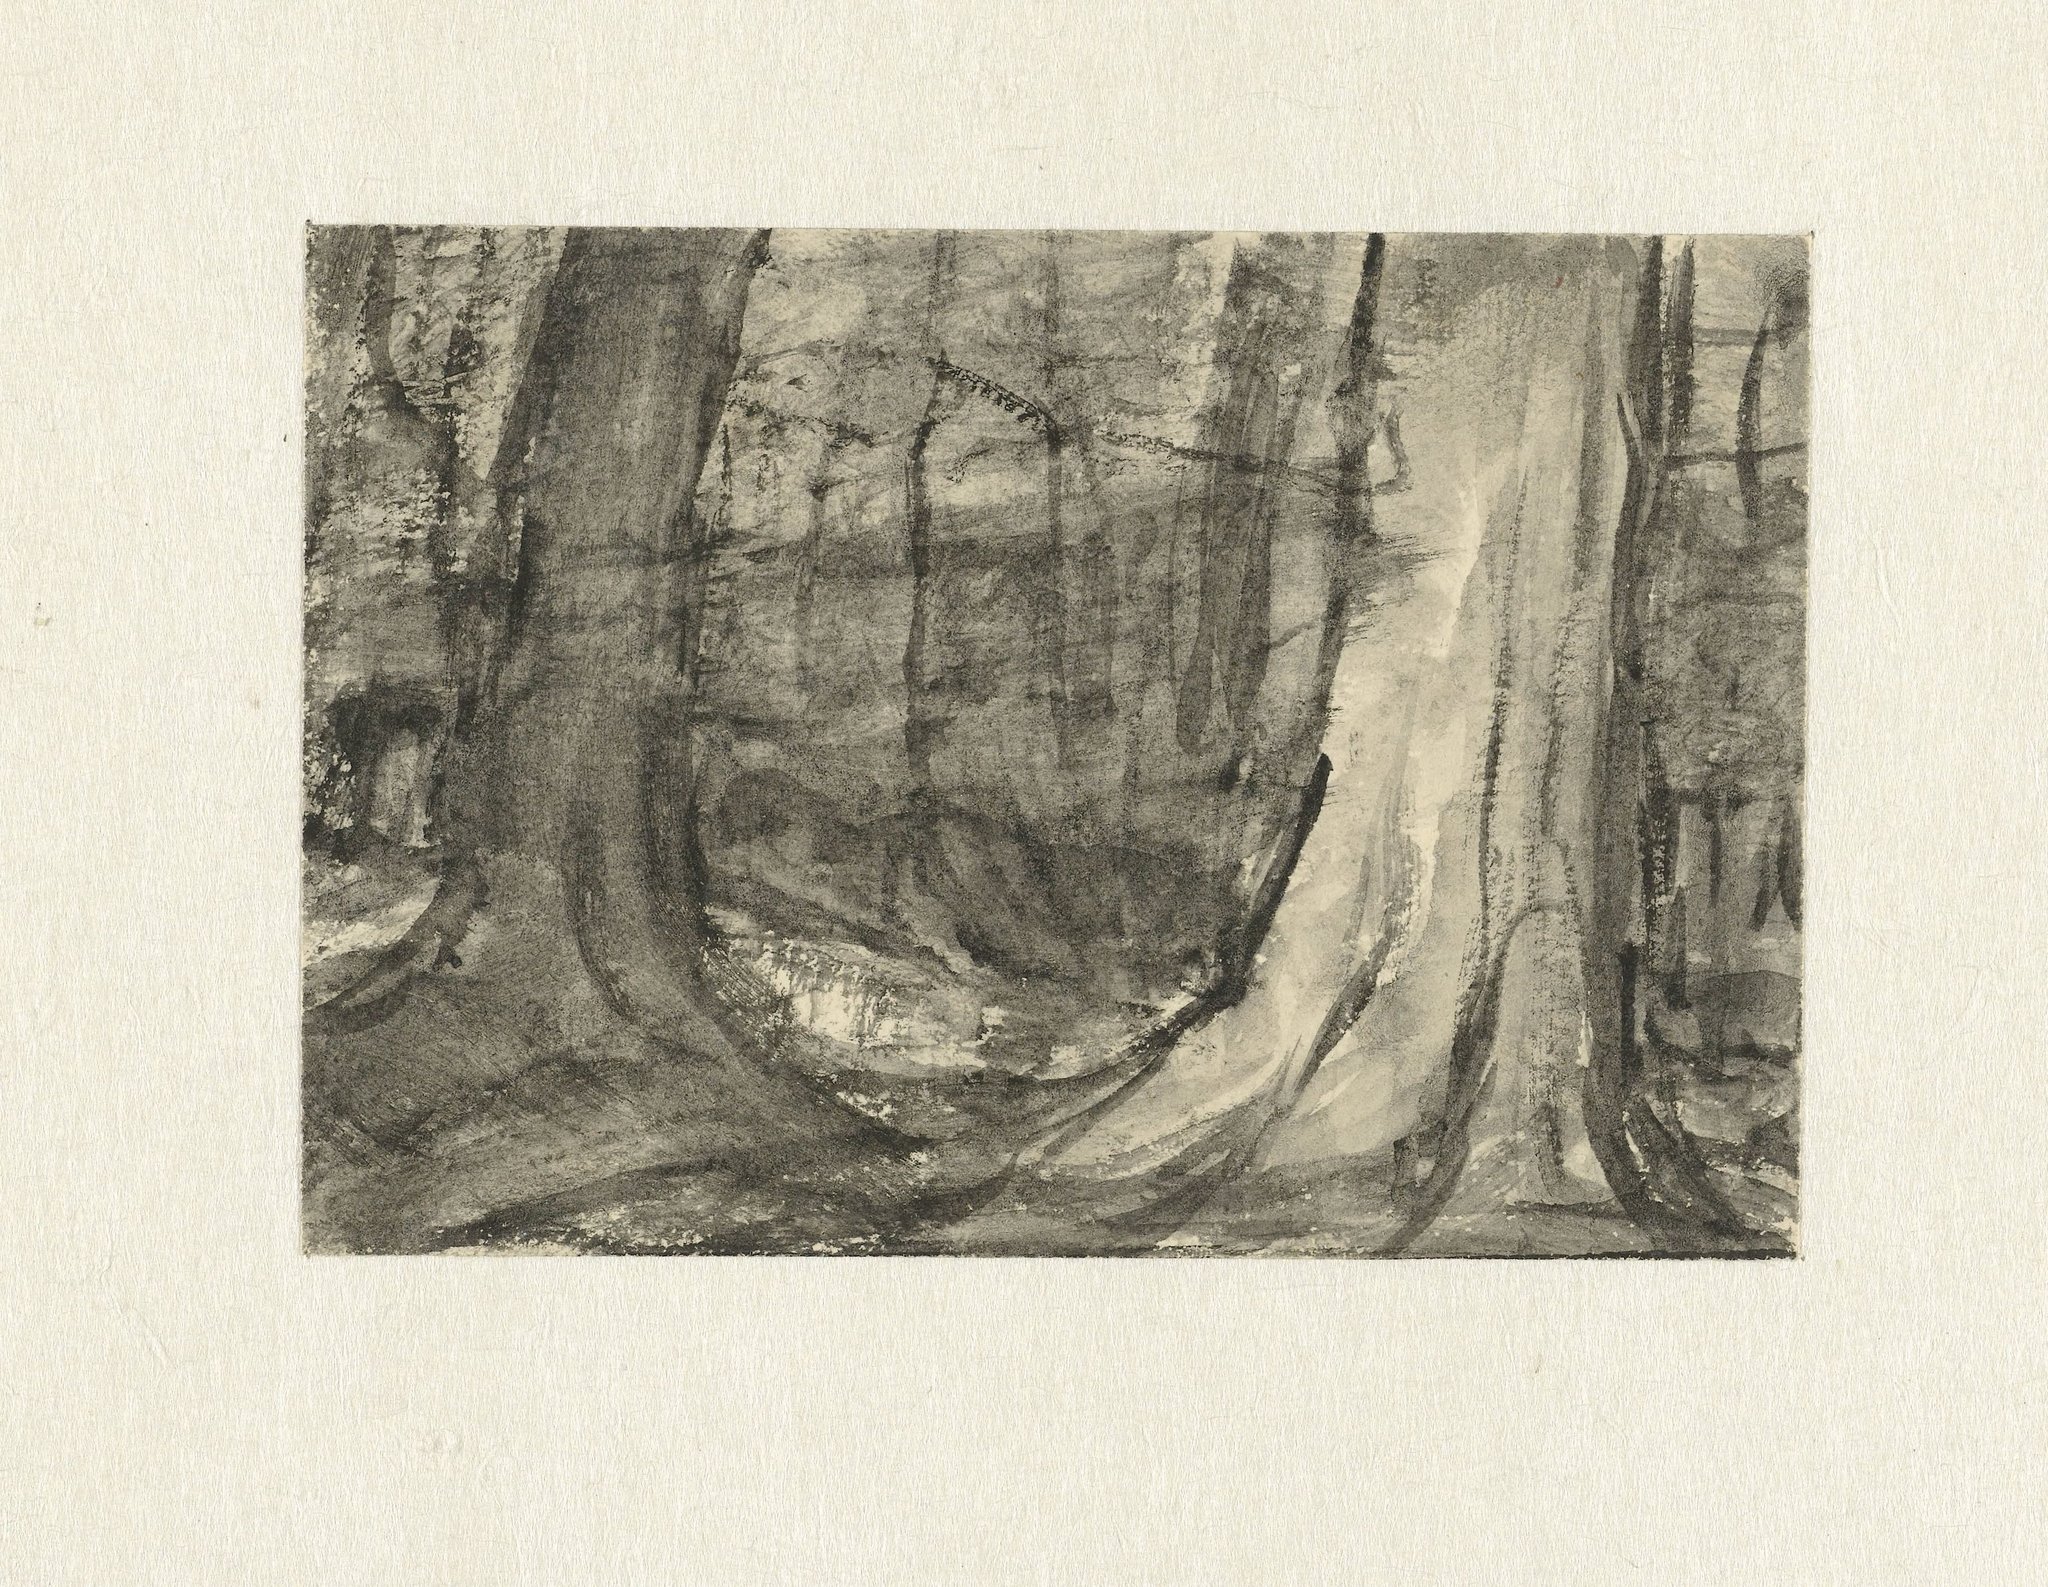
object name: drawing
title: Gezicht tussen bomen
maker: sientje mesdag-van houten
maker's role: draughtsman, painter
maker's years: 1834-1909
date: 1844-1909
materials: paper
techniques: brush